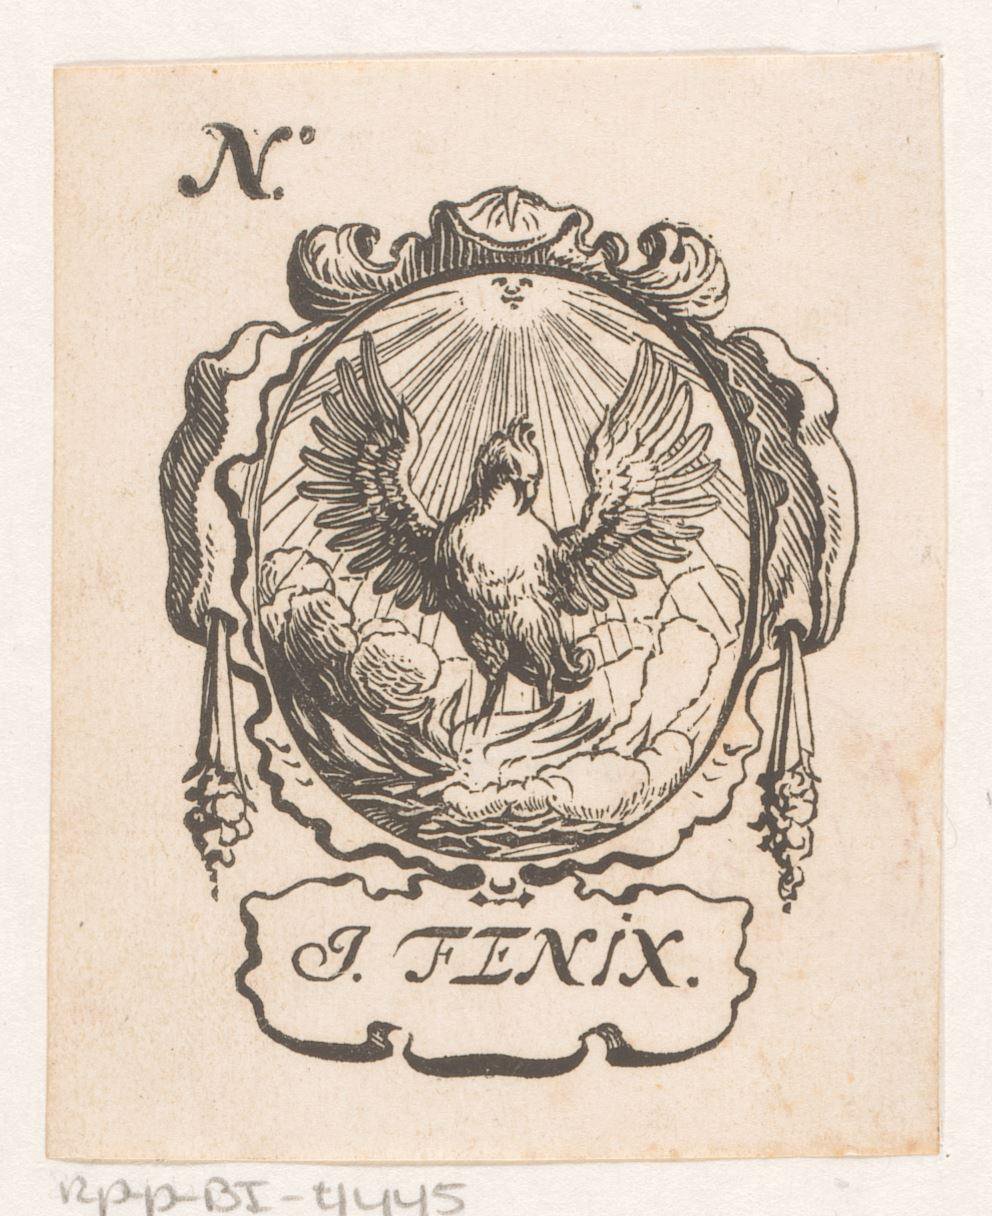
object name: print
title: Vignet met een brandende feniks in een nest die verrijst uit zijn eigen as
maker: Anonymous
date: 1600-1699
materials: paper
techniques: woodcut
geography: netherlands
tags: vignette, fabulous animals ~ birds: phoenix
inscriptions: collector's mark: Lugt 240